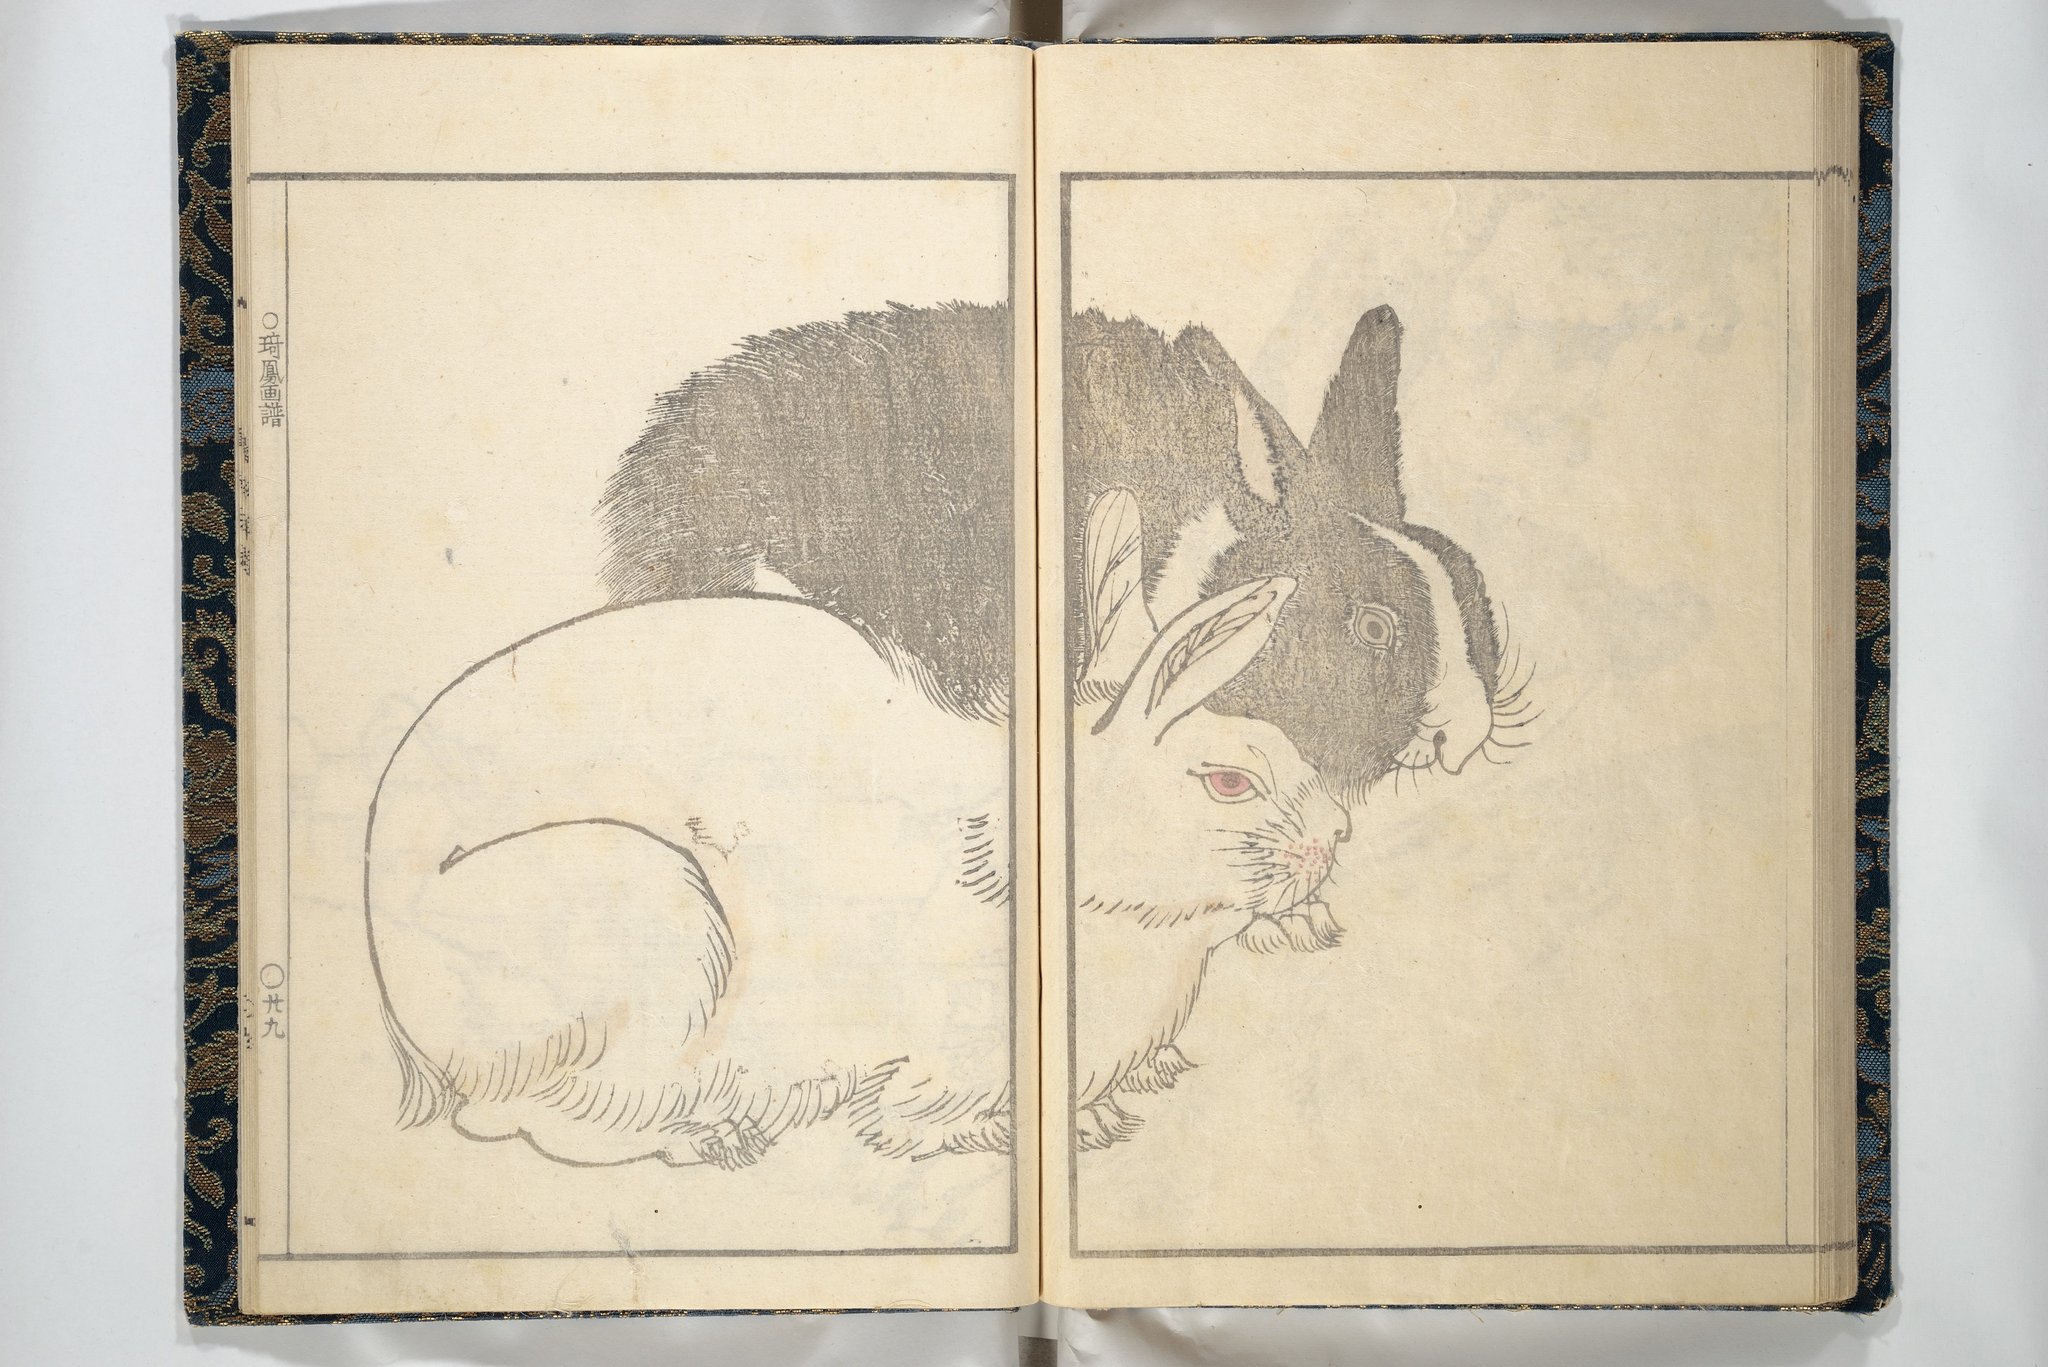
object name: illustrated book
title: Kihō Picture Album (Kihō gafu) 埼鳳画譜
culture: japanese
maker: kawamura kihō 河村琦鳳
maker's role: artist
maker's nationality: japanese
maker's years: 1778-1852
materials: ink, paper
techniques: woodblock print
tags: rabbits